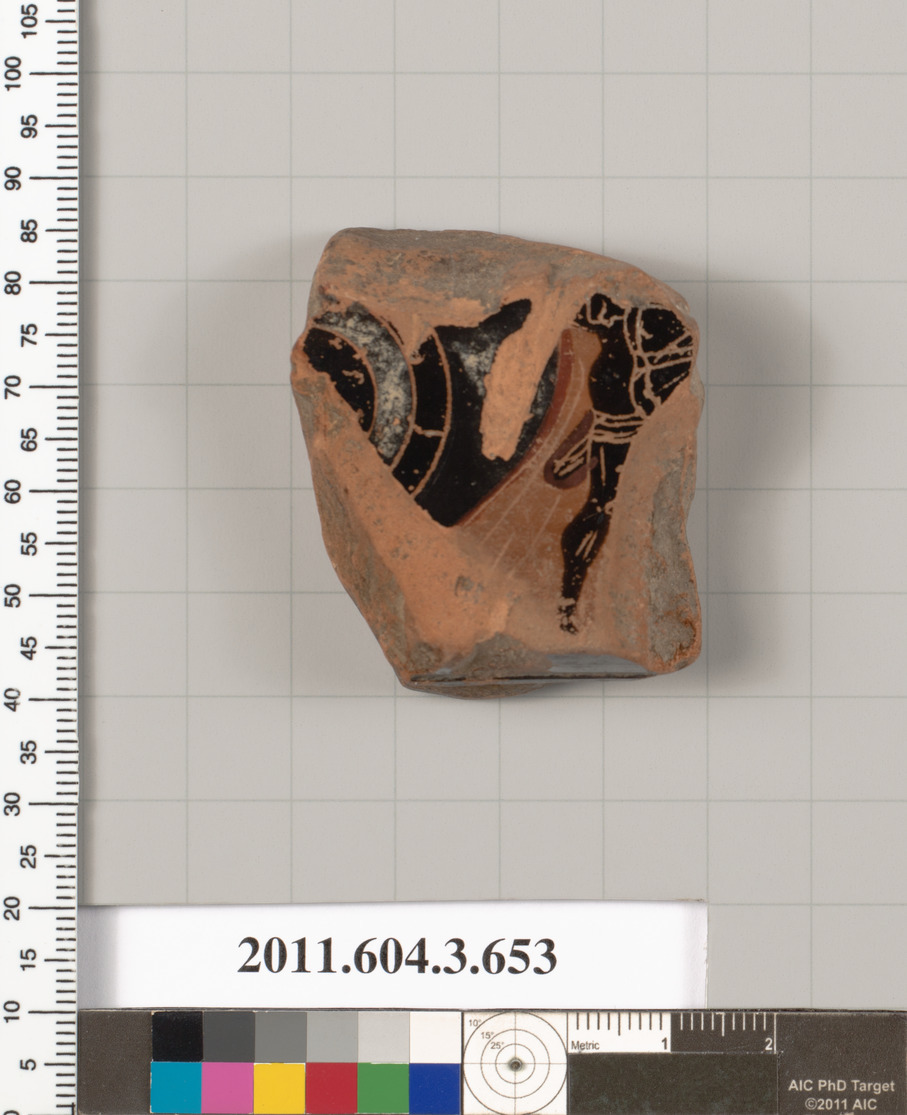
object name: volute krater fragment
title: Terracotta fragment of a volute-krater (bowl for mixing wine and water)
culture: greek, attic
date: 520-510 BCE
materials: terracotta